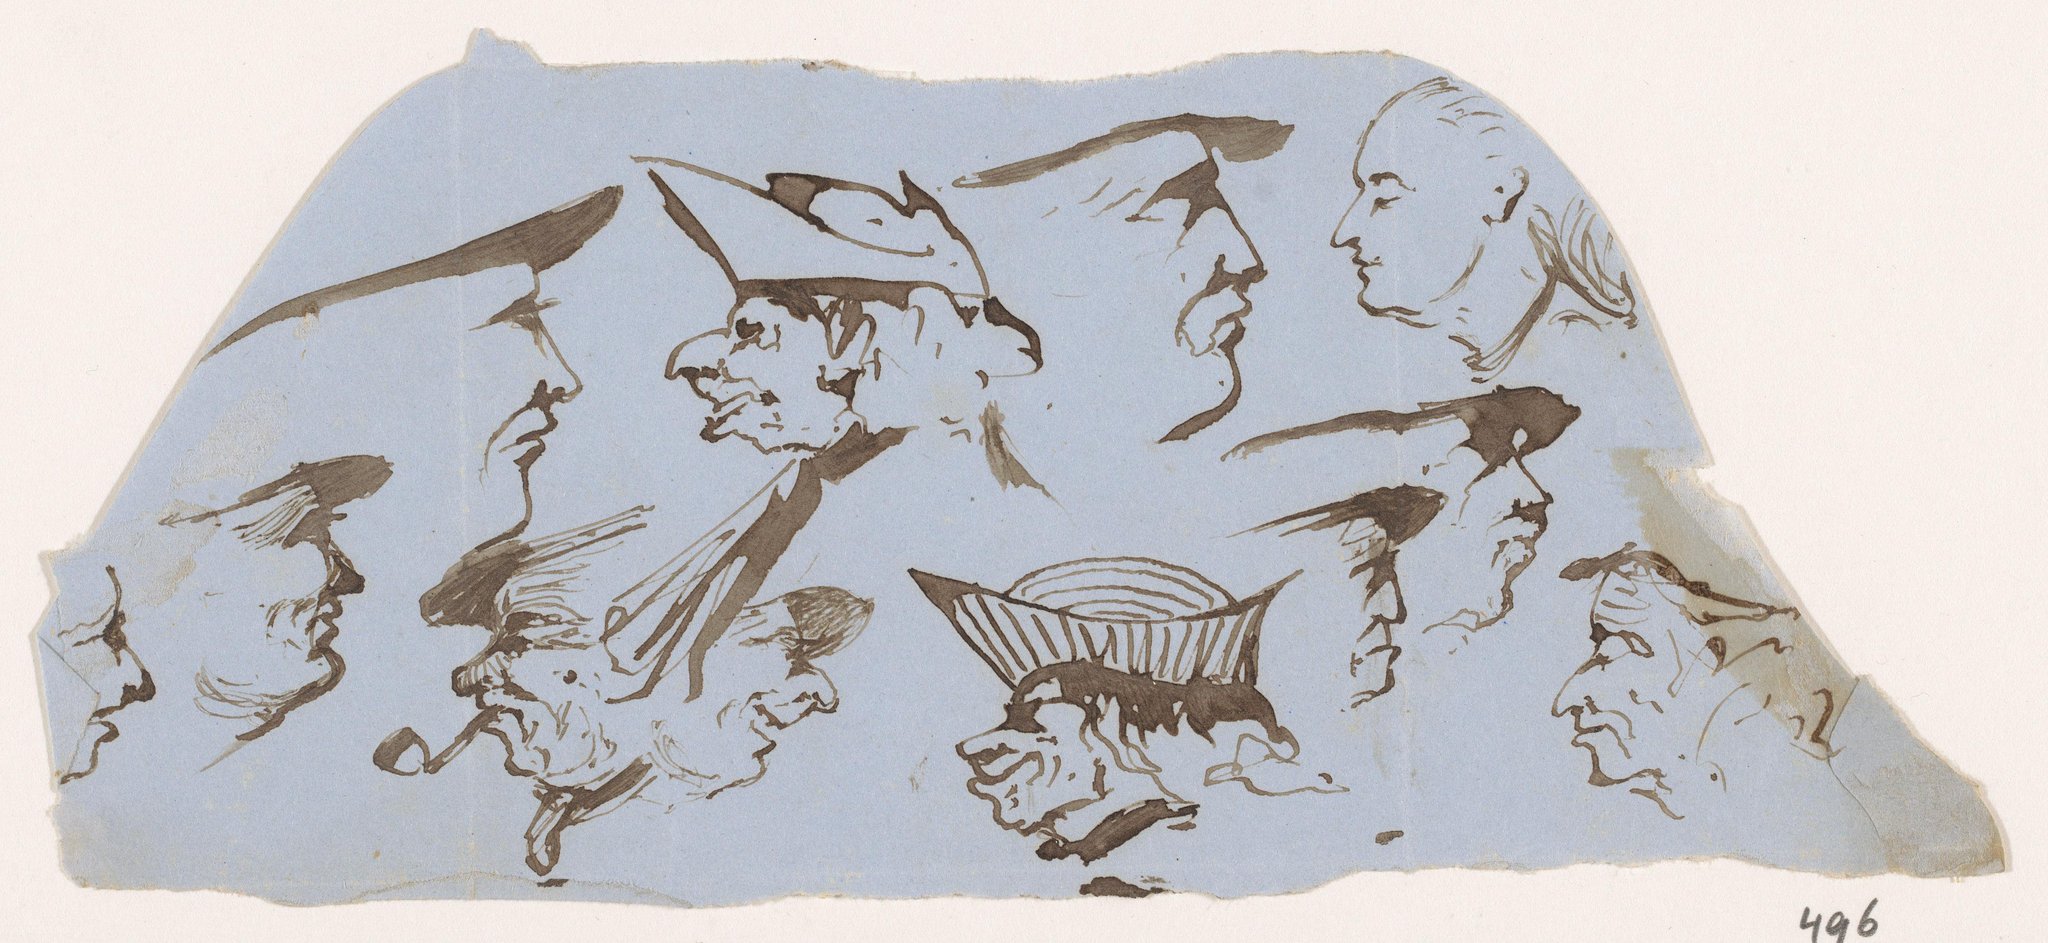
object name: drawing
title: Blad met koppen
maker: johannes tavenraat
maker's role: draughtsman, painter, print maker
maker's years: 1809-1881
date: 1840-1880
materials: ink, paper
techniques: pen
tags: caricatures (human types)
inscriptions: collector's mark: Lugt 2228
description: Blad met koppen. Getekend op de achterzijde van een deel van een envelop gericht aan J. Tavenraat.